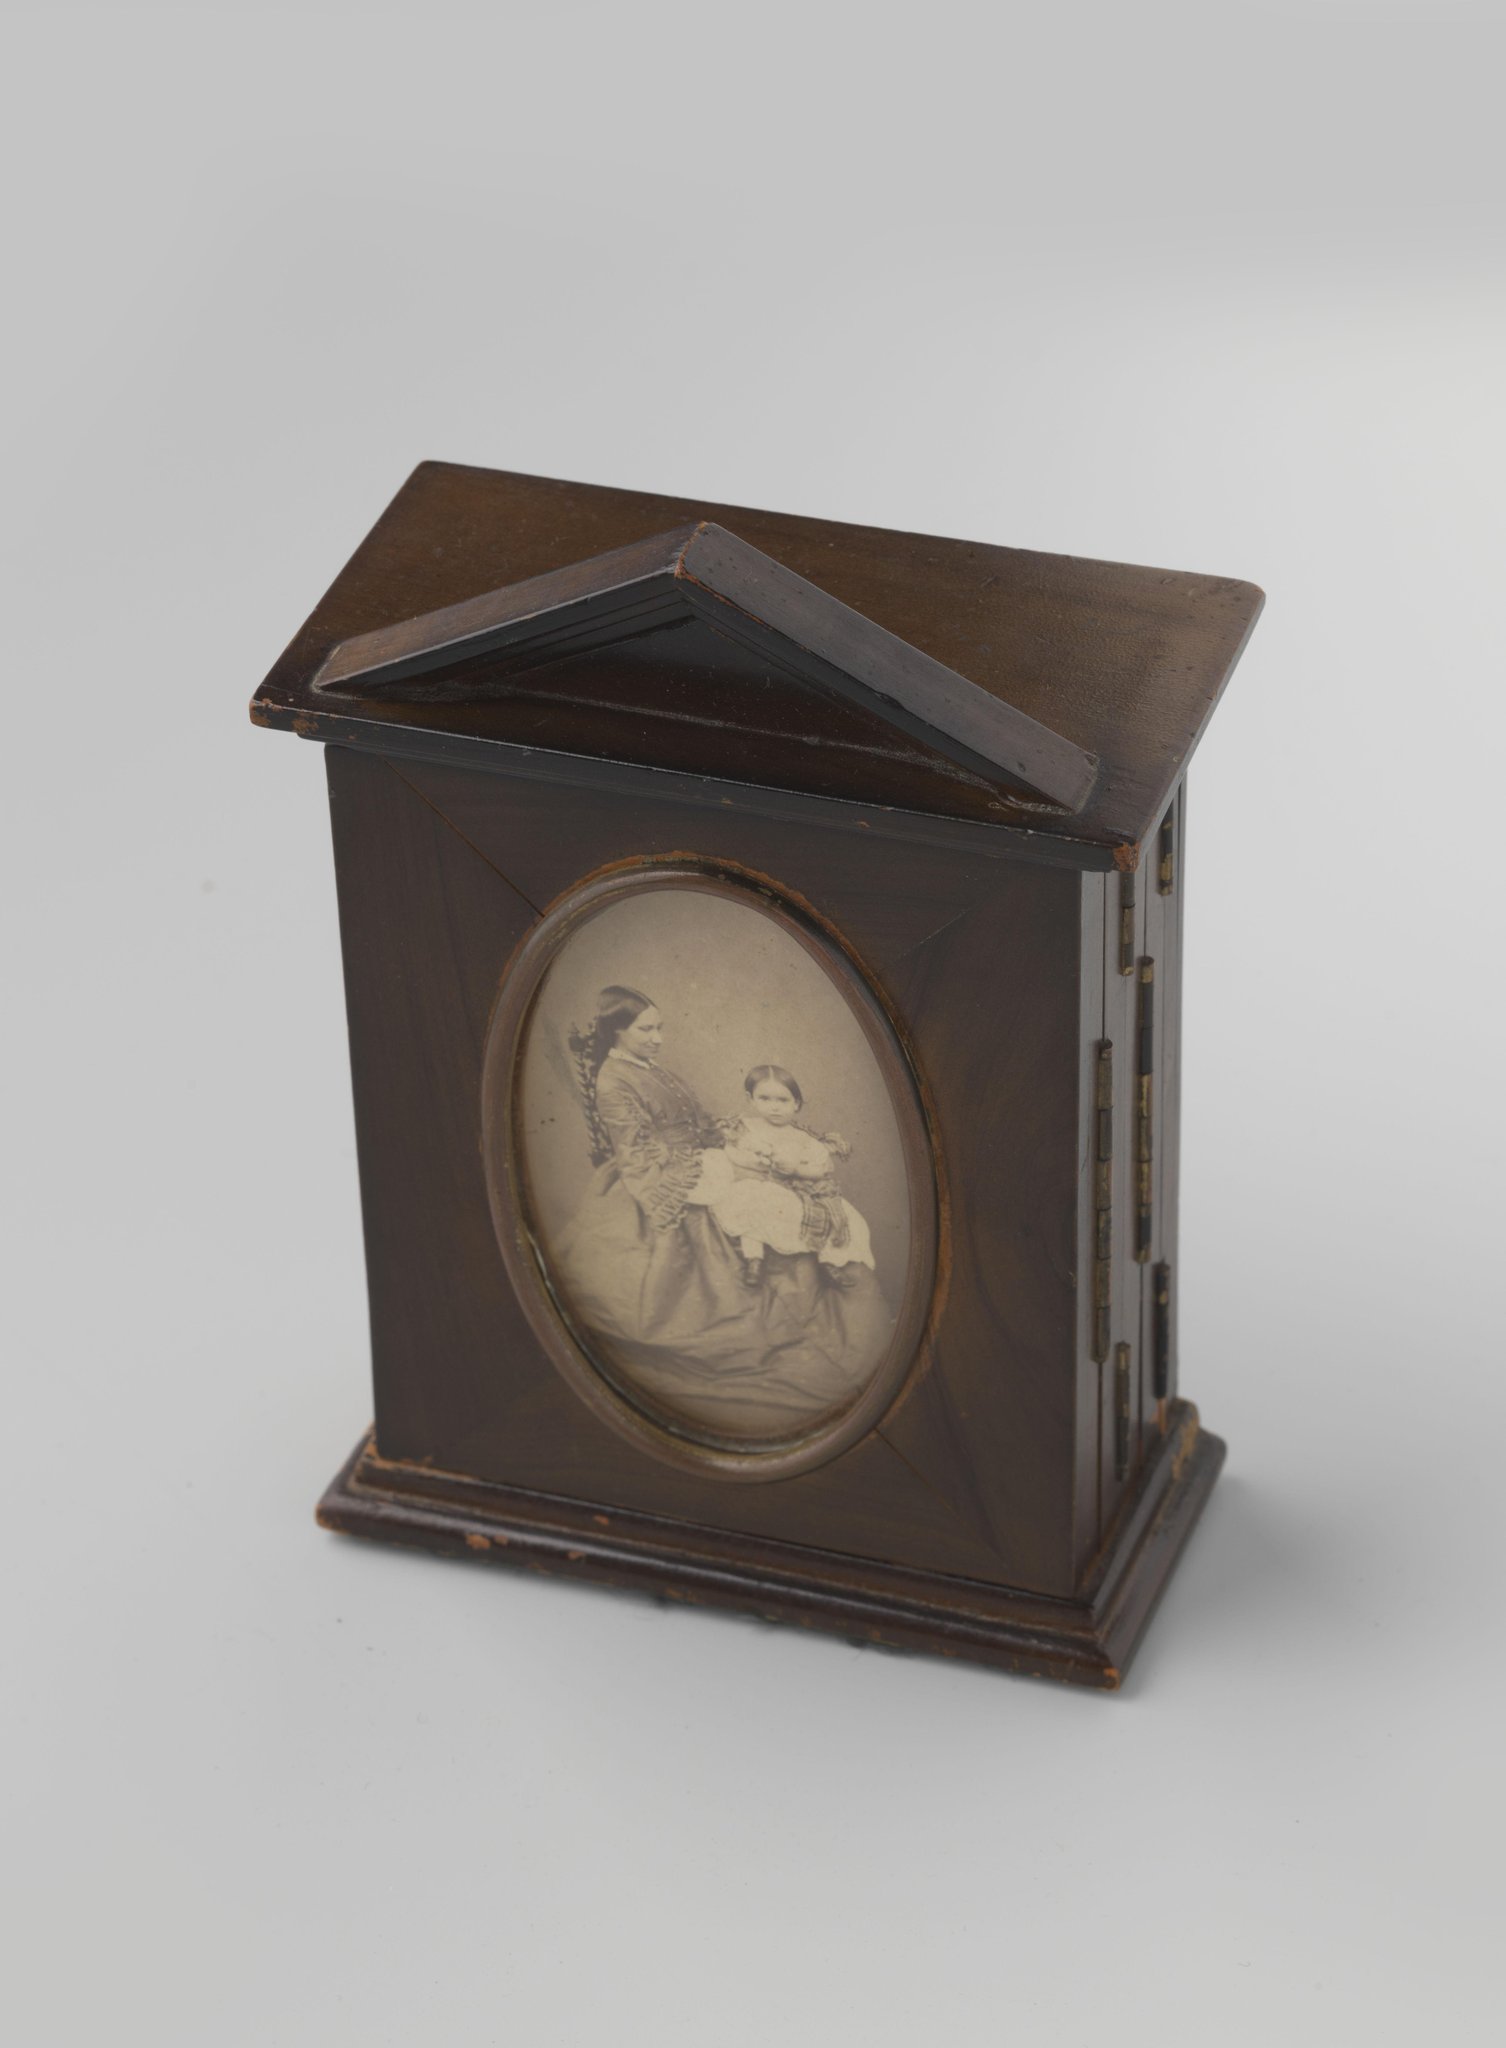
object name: frame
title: Houder met uitklapbare lijsten met negen portretten van onbekende mensen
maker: Anonymous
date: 1880-1900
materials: glass, metal, paper, textile, wood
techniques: albumen print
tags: anonymous historical person portrayed